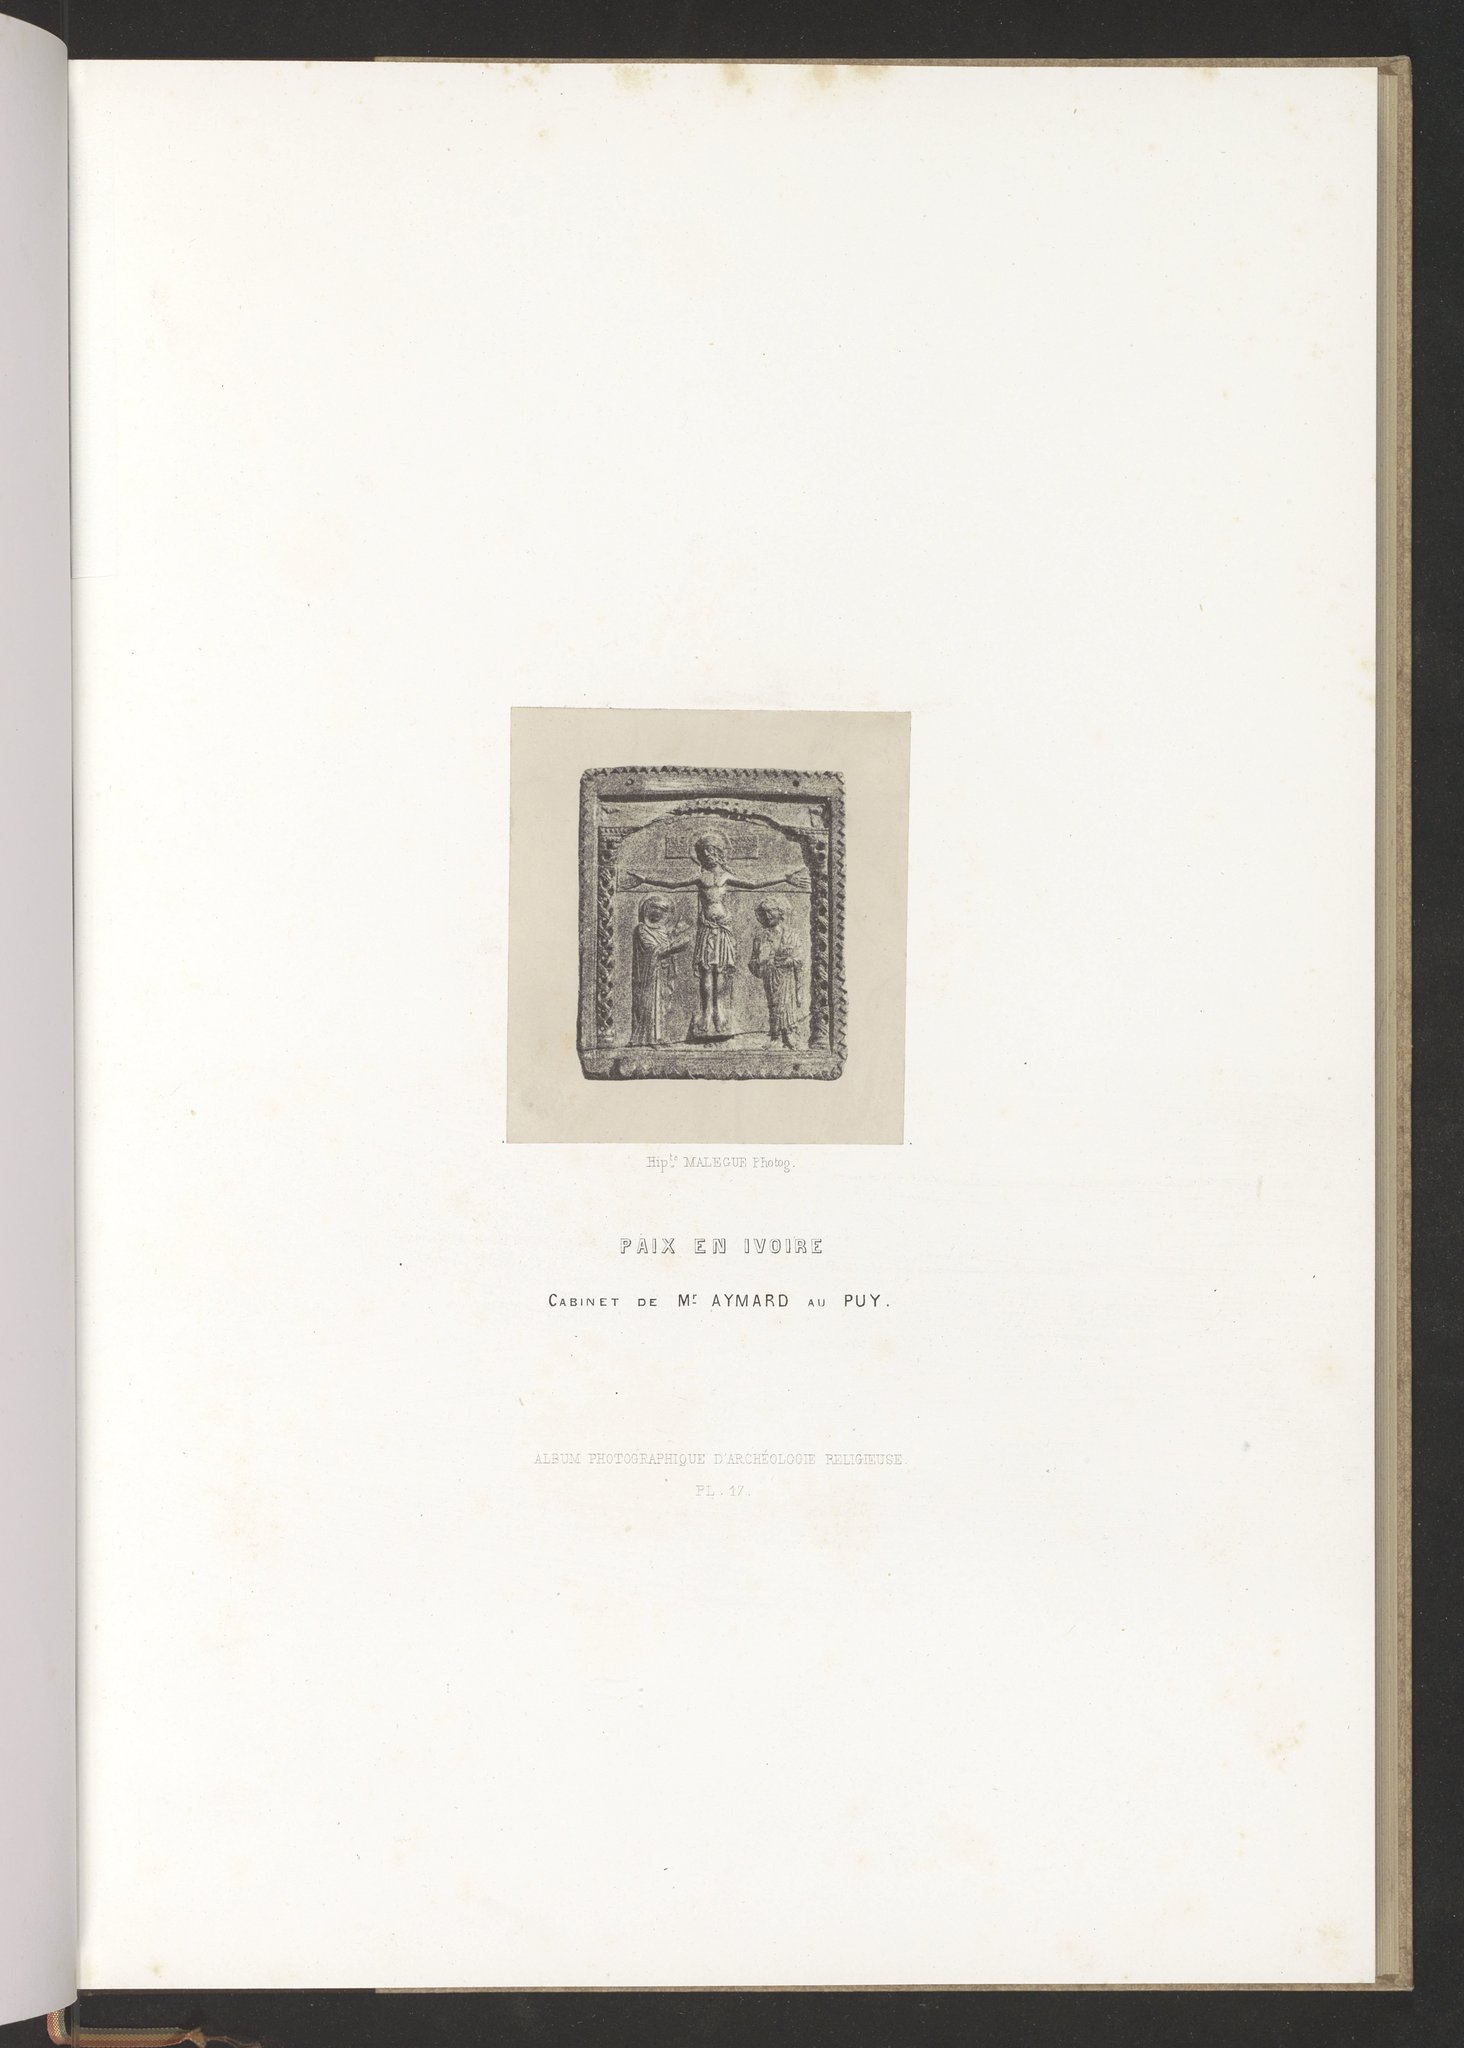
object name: photograph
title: Ivoren reliëf met de Kruisiging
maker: hippolyte malègue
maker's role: archeoloog, fotograaf, schrijver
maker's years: 1825-1901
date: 1850-1857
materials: photographic support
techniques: salted paper print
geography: france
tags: the crucifixion of christ: christ's death on the cross; golgotha (matthew 27:45-58; mark 15:33-45; luke 23:44-52; john 19:25-38), sculpture (+ relief ~ sculpture)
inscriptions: number: ‘PL. 17.’, inscription: ‘cabinet de Mr Aumard au Puy.’